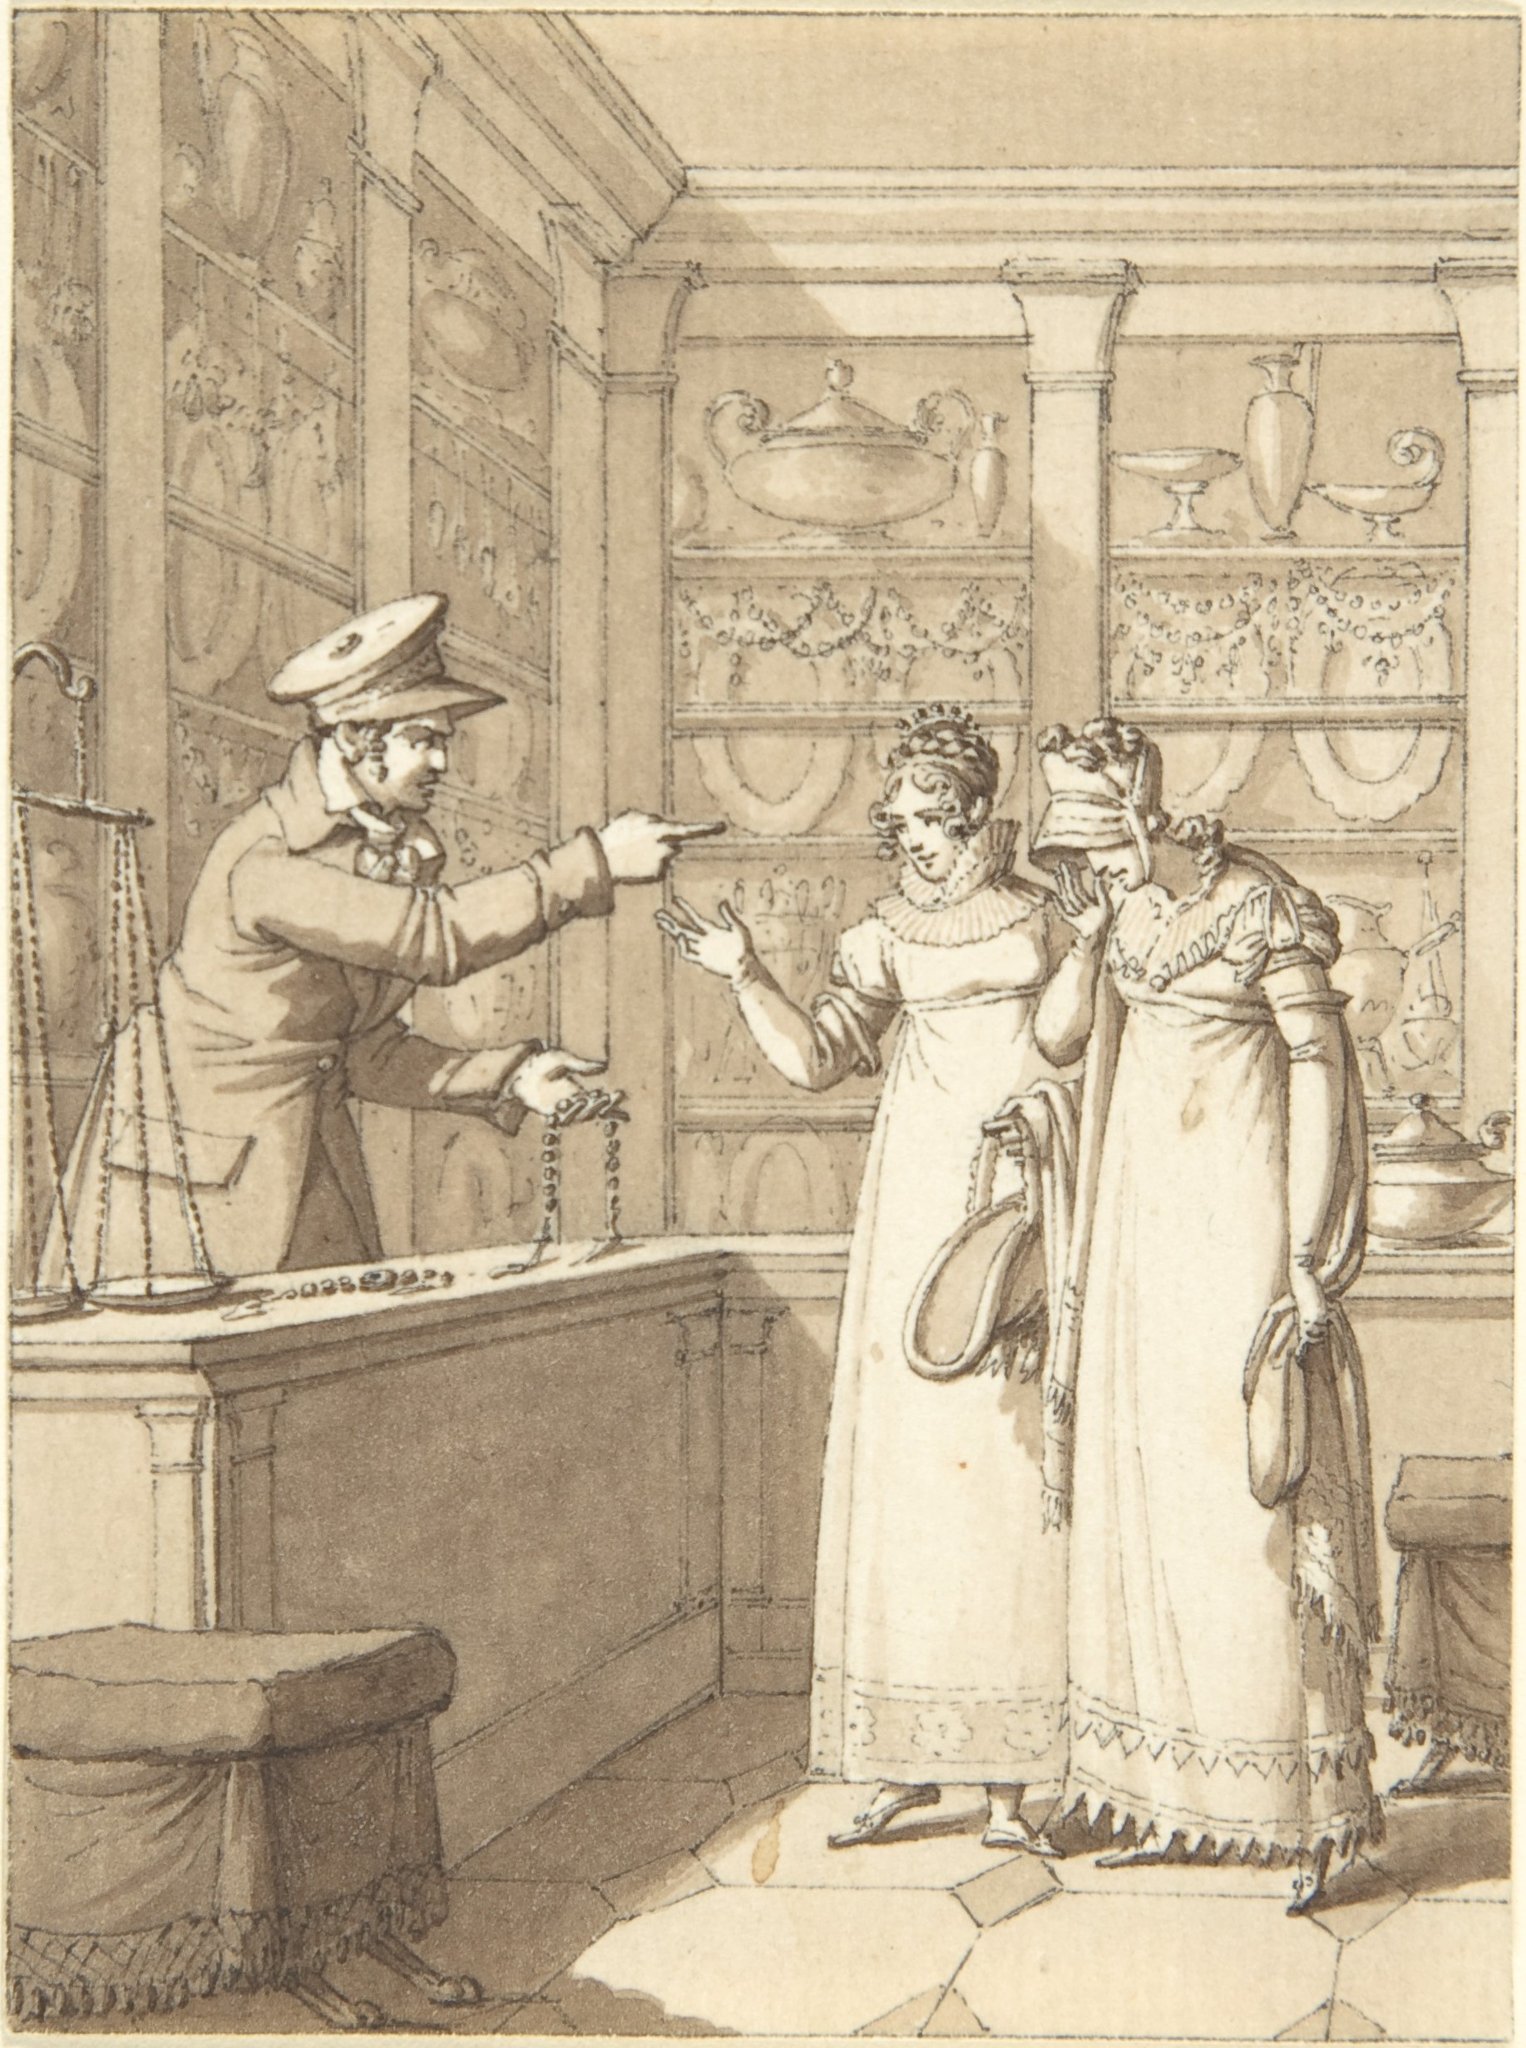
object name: drawing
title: Design for a Book Illustration: Two Women in a Pawn Shop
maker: anonymous, german, 19th century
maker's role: artist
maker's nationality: german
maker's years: 1800-1899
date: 1801-1900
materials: ink, paper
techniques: brush, pen, wash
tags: jewelry,men,women,scales